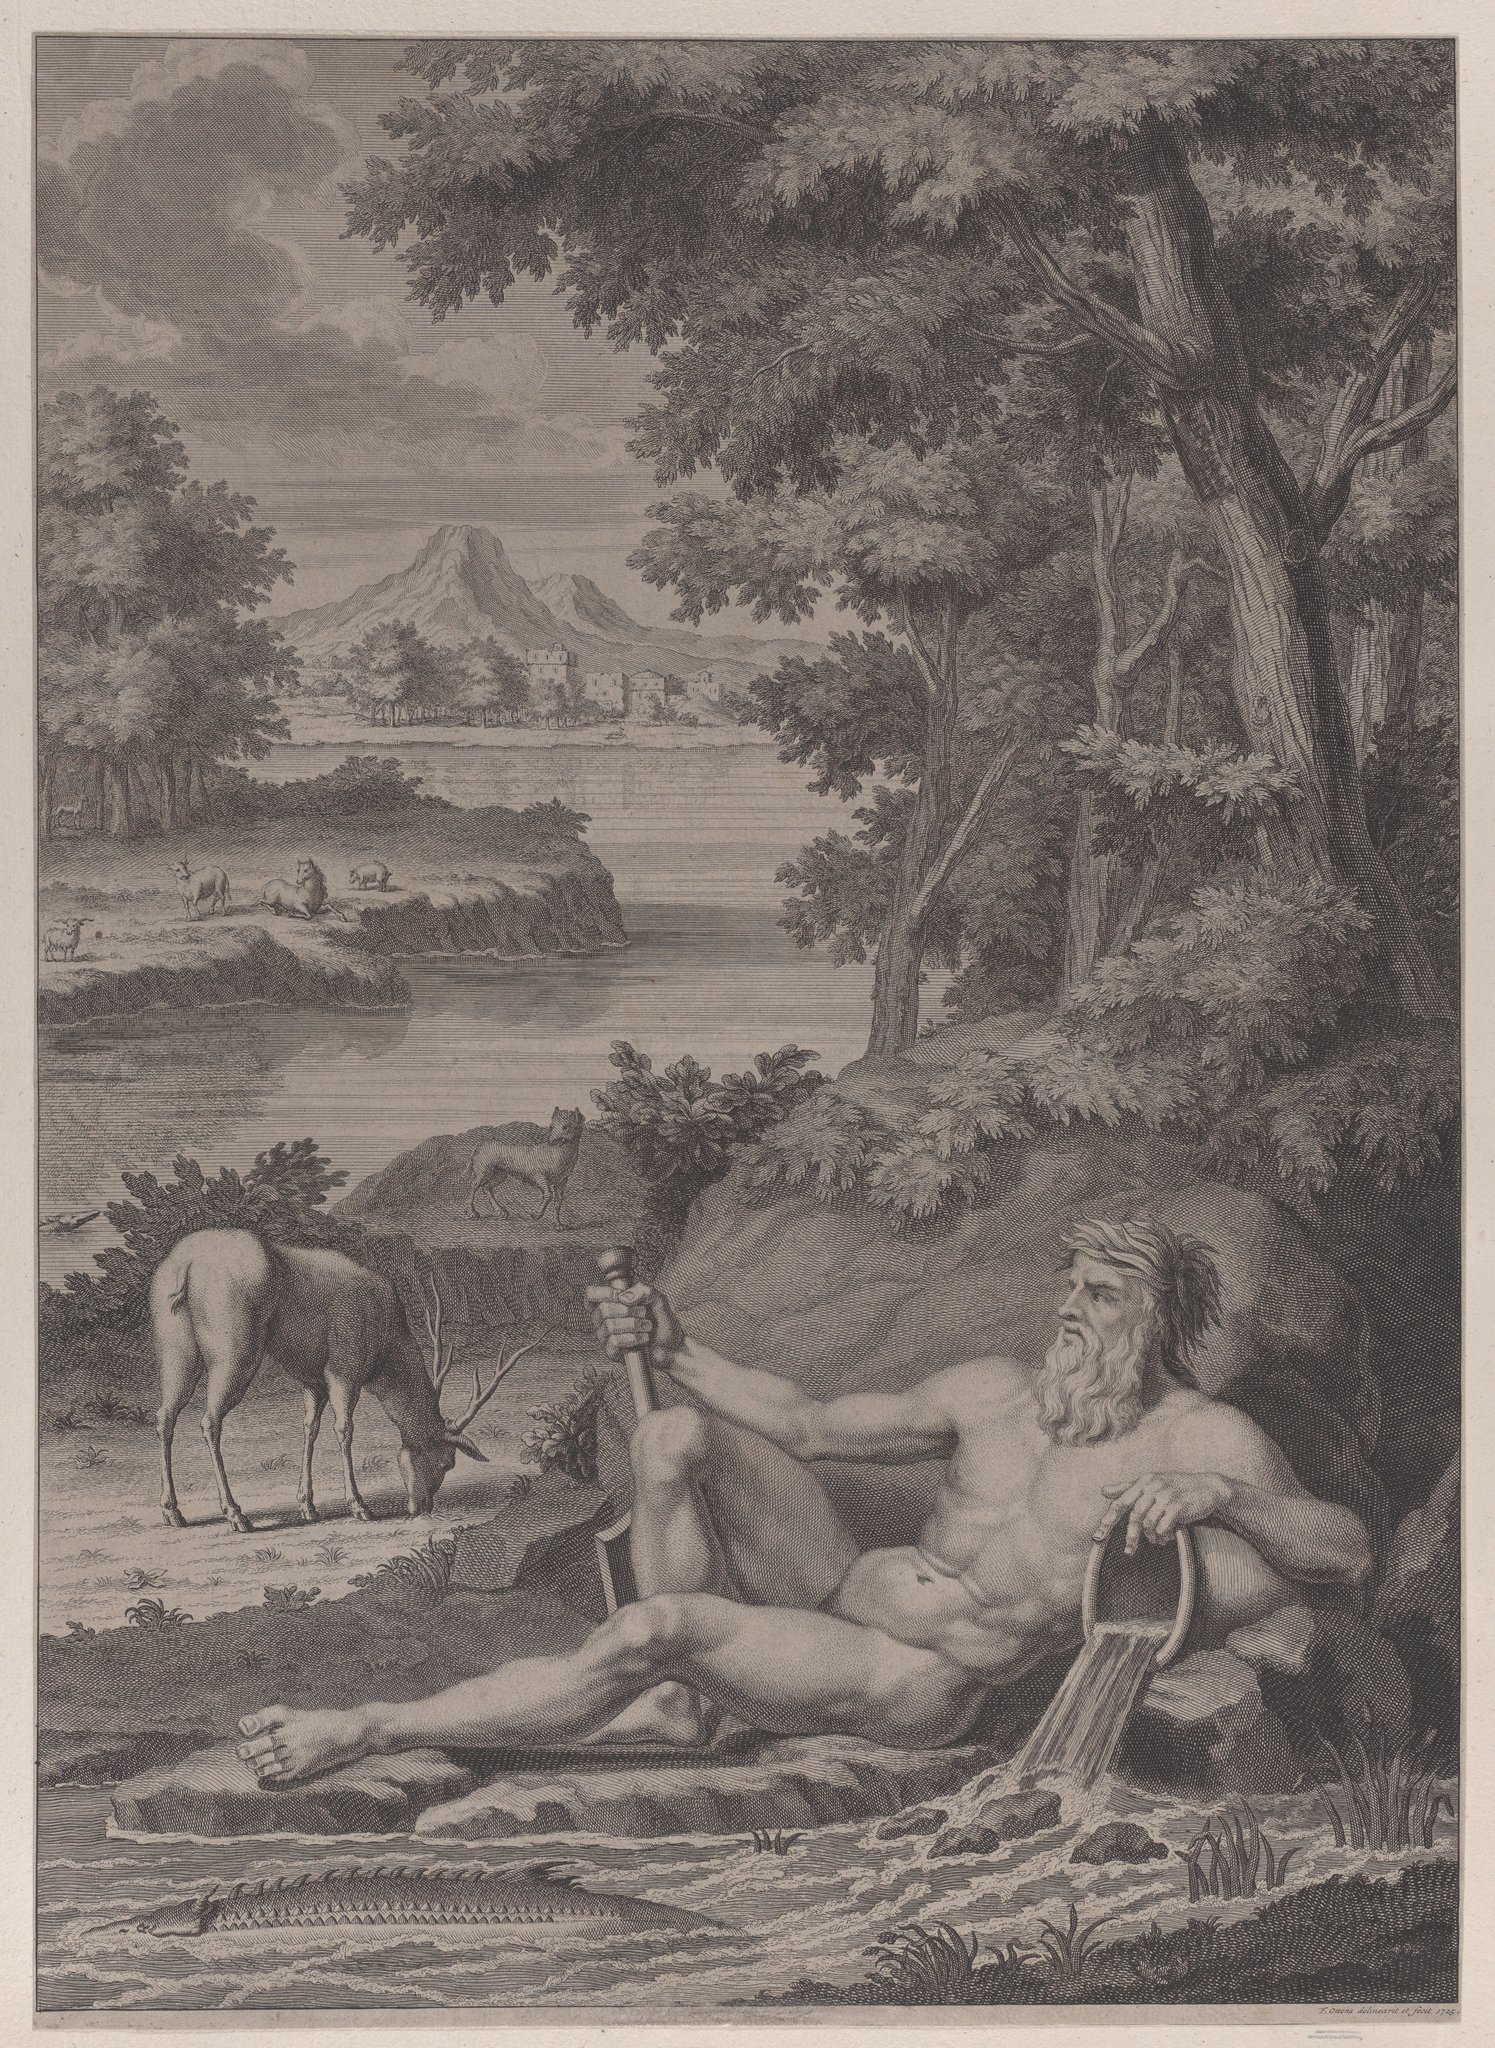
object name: print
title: River god in a landscape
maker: frederik ottens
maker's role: artist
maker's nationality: dutch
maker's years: 1675-1775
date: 1725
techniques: etching